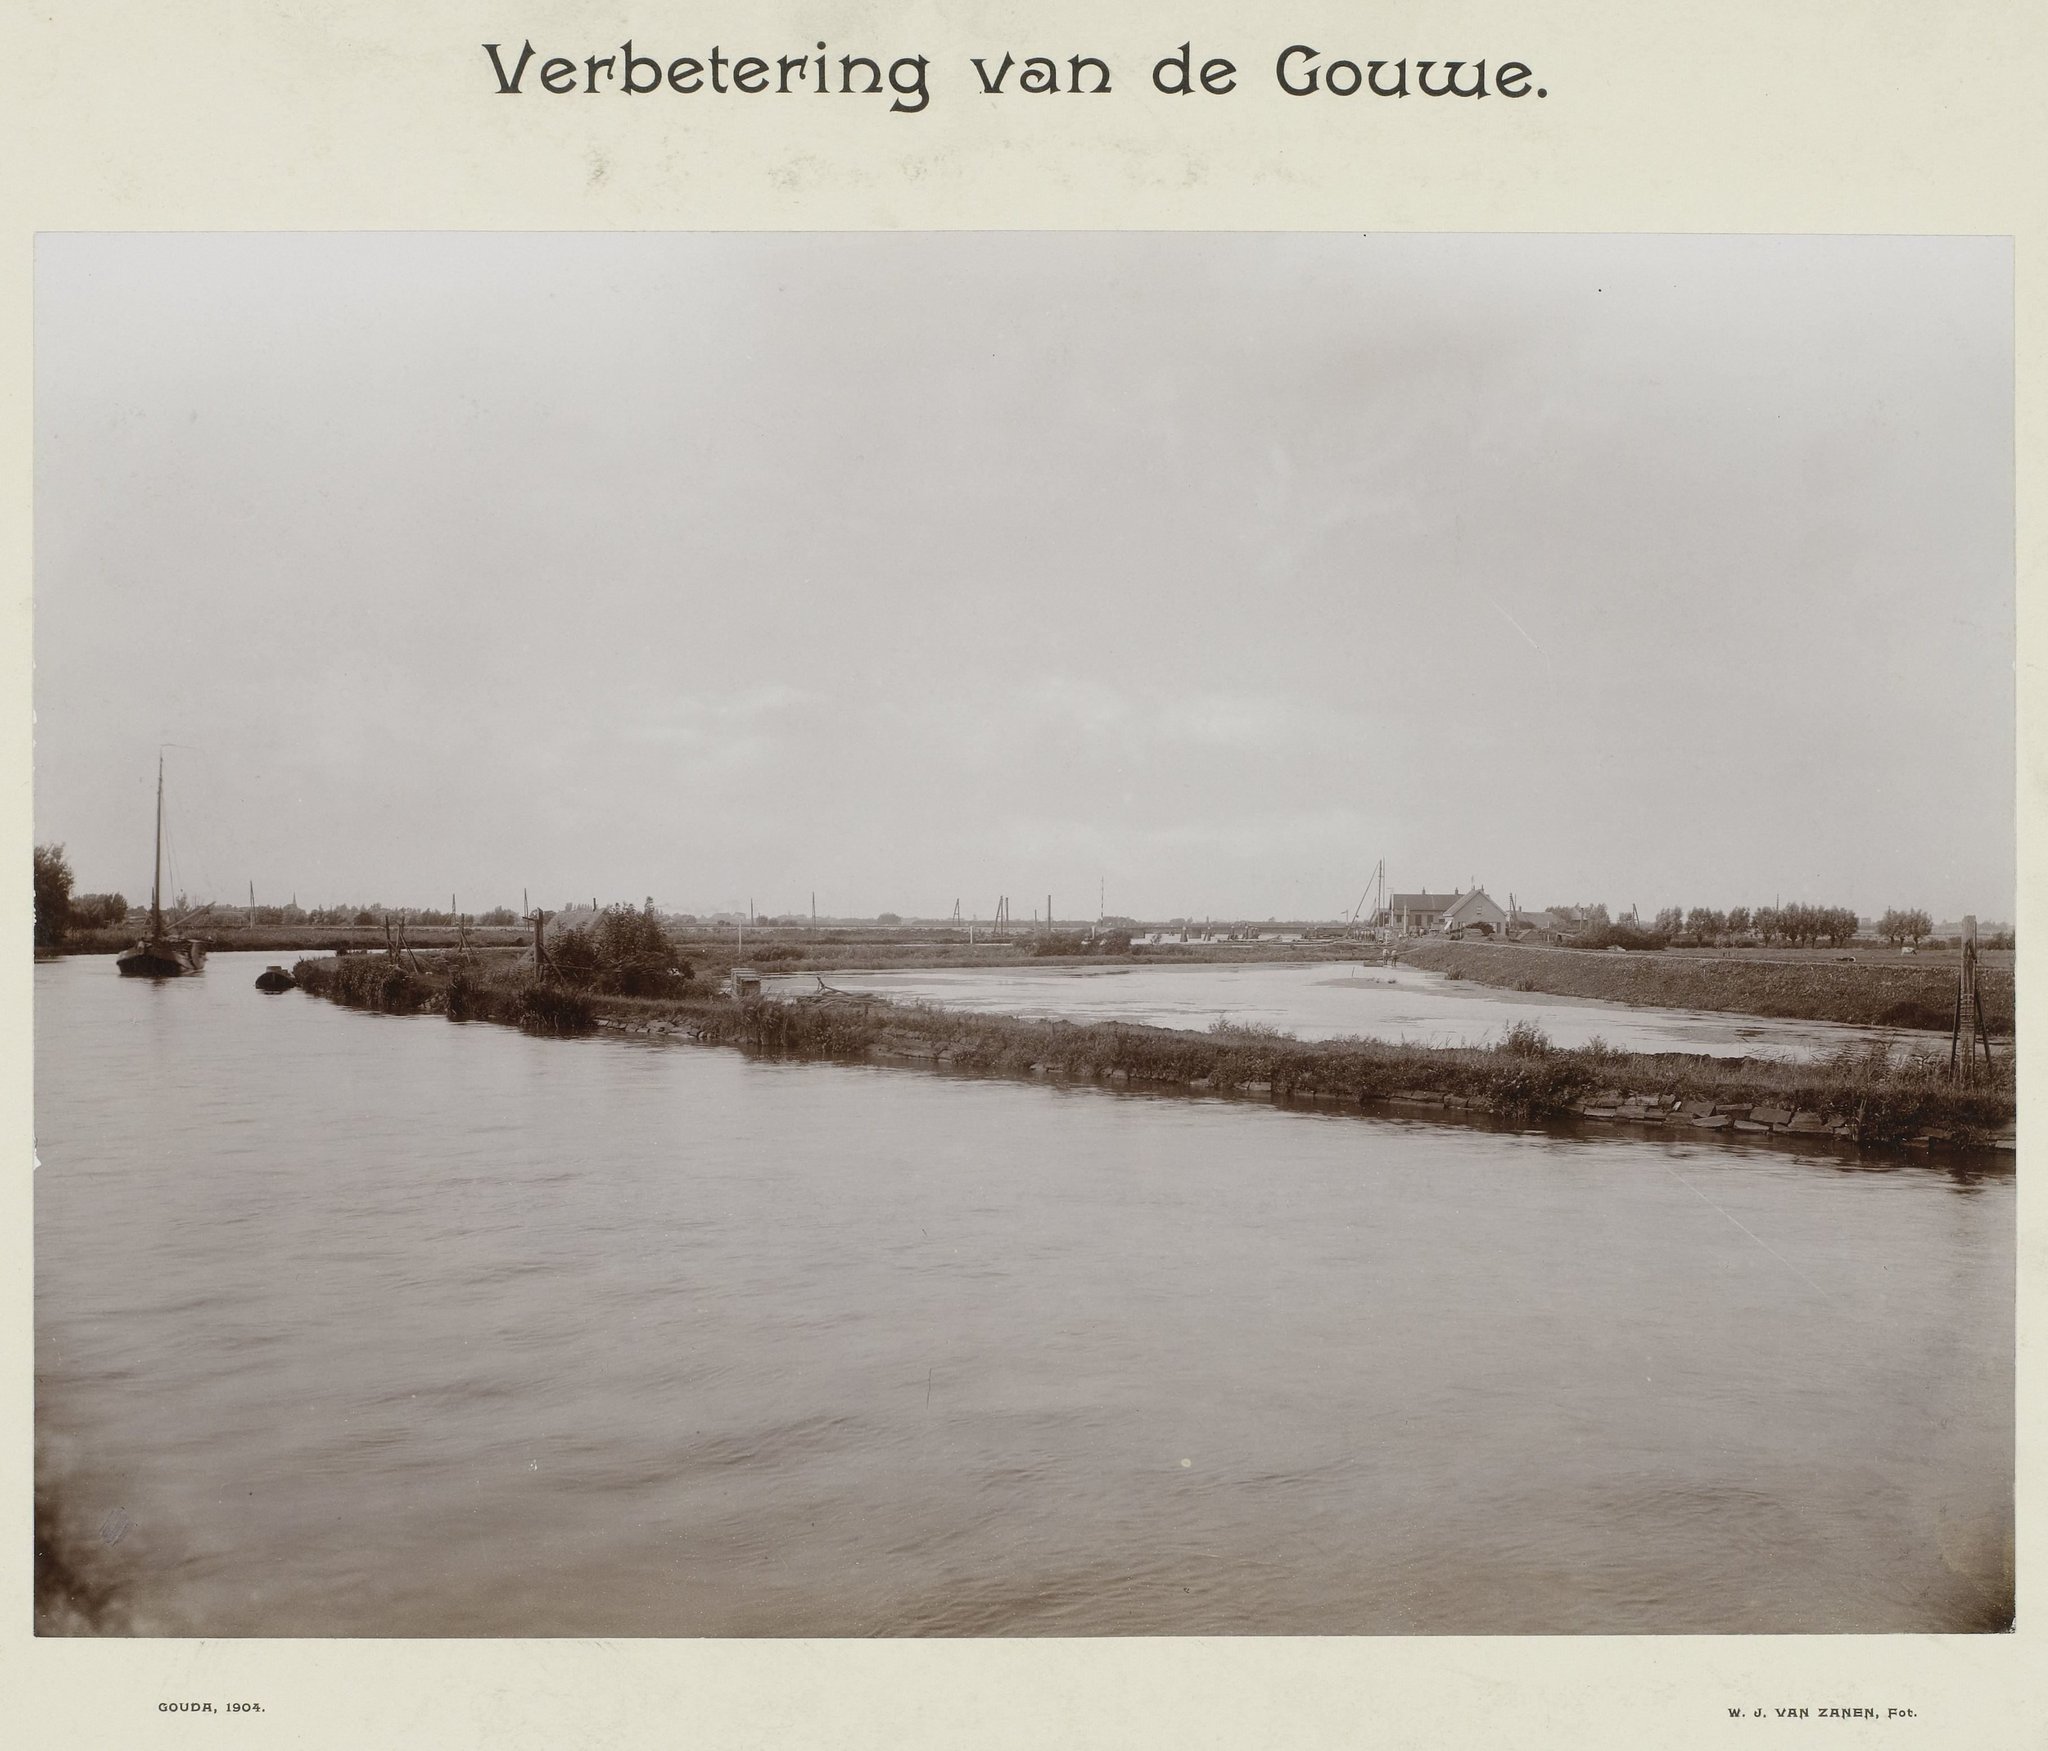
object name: photograph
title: Verbetering van de Gouwe.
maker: weijert jan van zanen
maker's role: fotograaf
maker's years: 1873-1960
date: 1904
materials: cardboard, paper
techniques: photography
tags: gouda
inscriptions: date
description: Foto op karton van waterbouwkundige werken (verbeteringen die in 1904 aan de Gouwe te Gouda zijn aangebracht). Gedateeerd en gesigneerd.